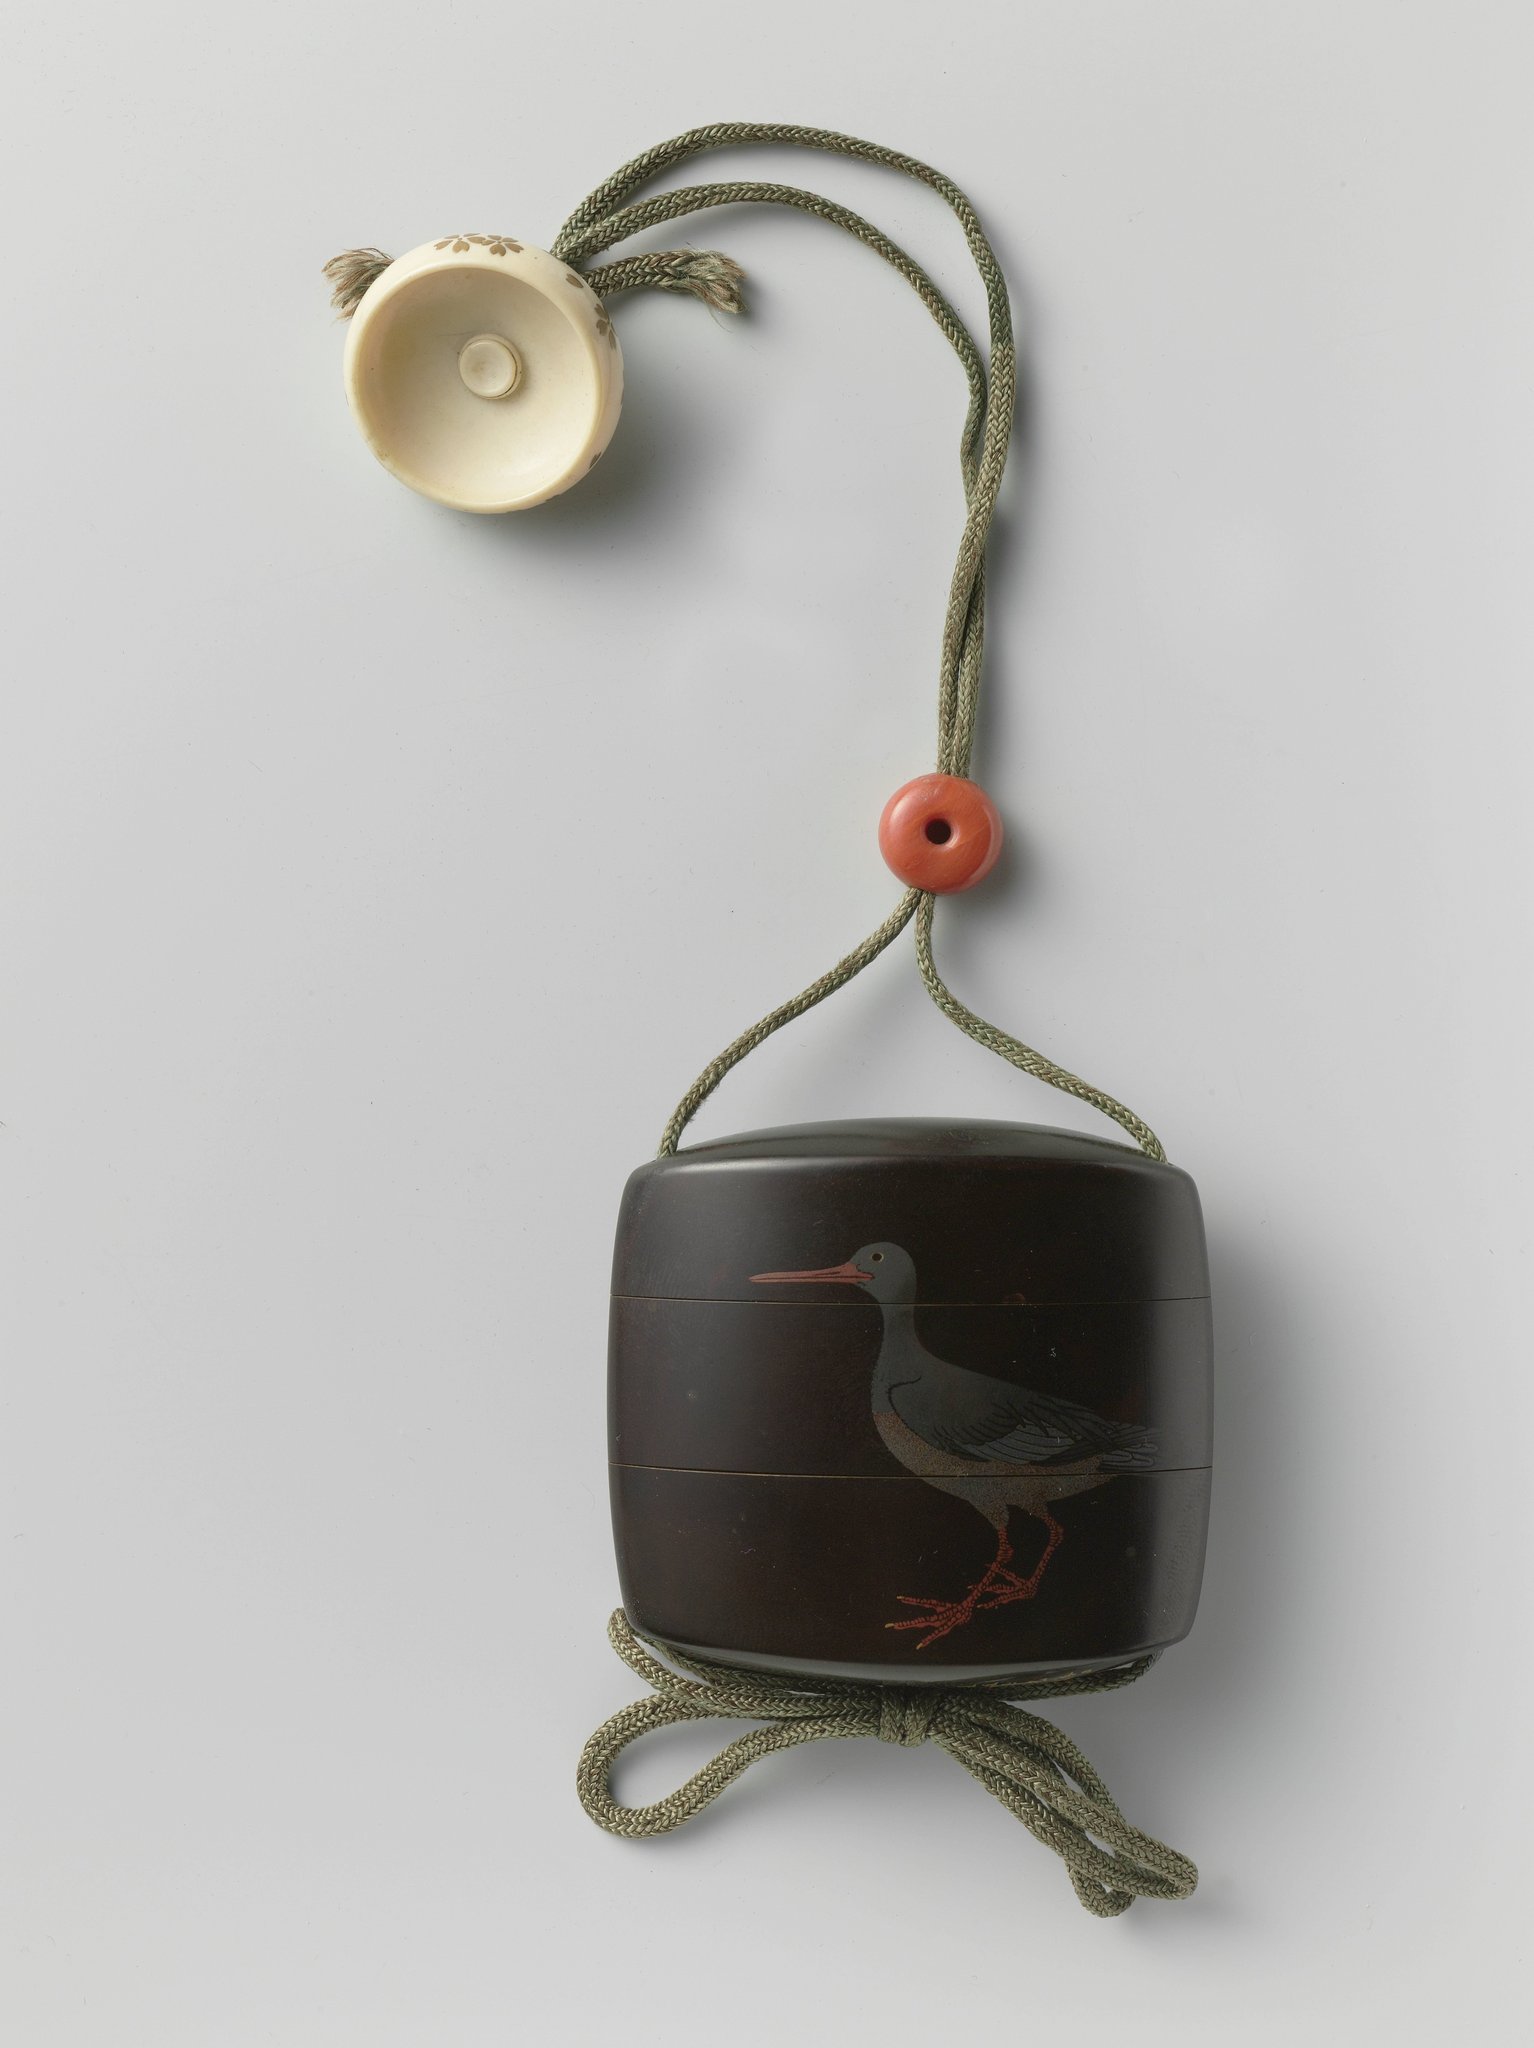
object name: inrō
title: Inro with bird, netsuke with blossoms, ojime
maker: Anonymous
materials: lacquer, wood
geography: japan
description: Tegen het zwarte fond aan de ene zijde een plevier in o.a. rood en grijs; aan de andere zijde de Kamo rivier met door storm bewogen planten in goud. Aan de onderzijde in goud gesigneerd "toshihide" met leeftijd en jaartal en stempel.